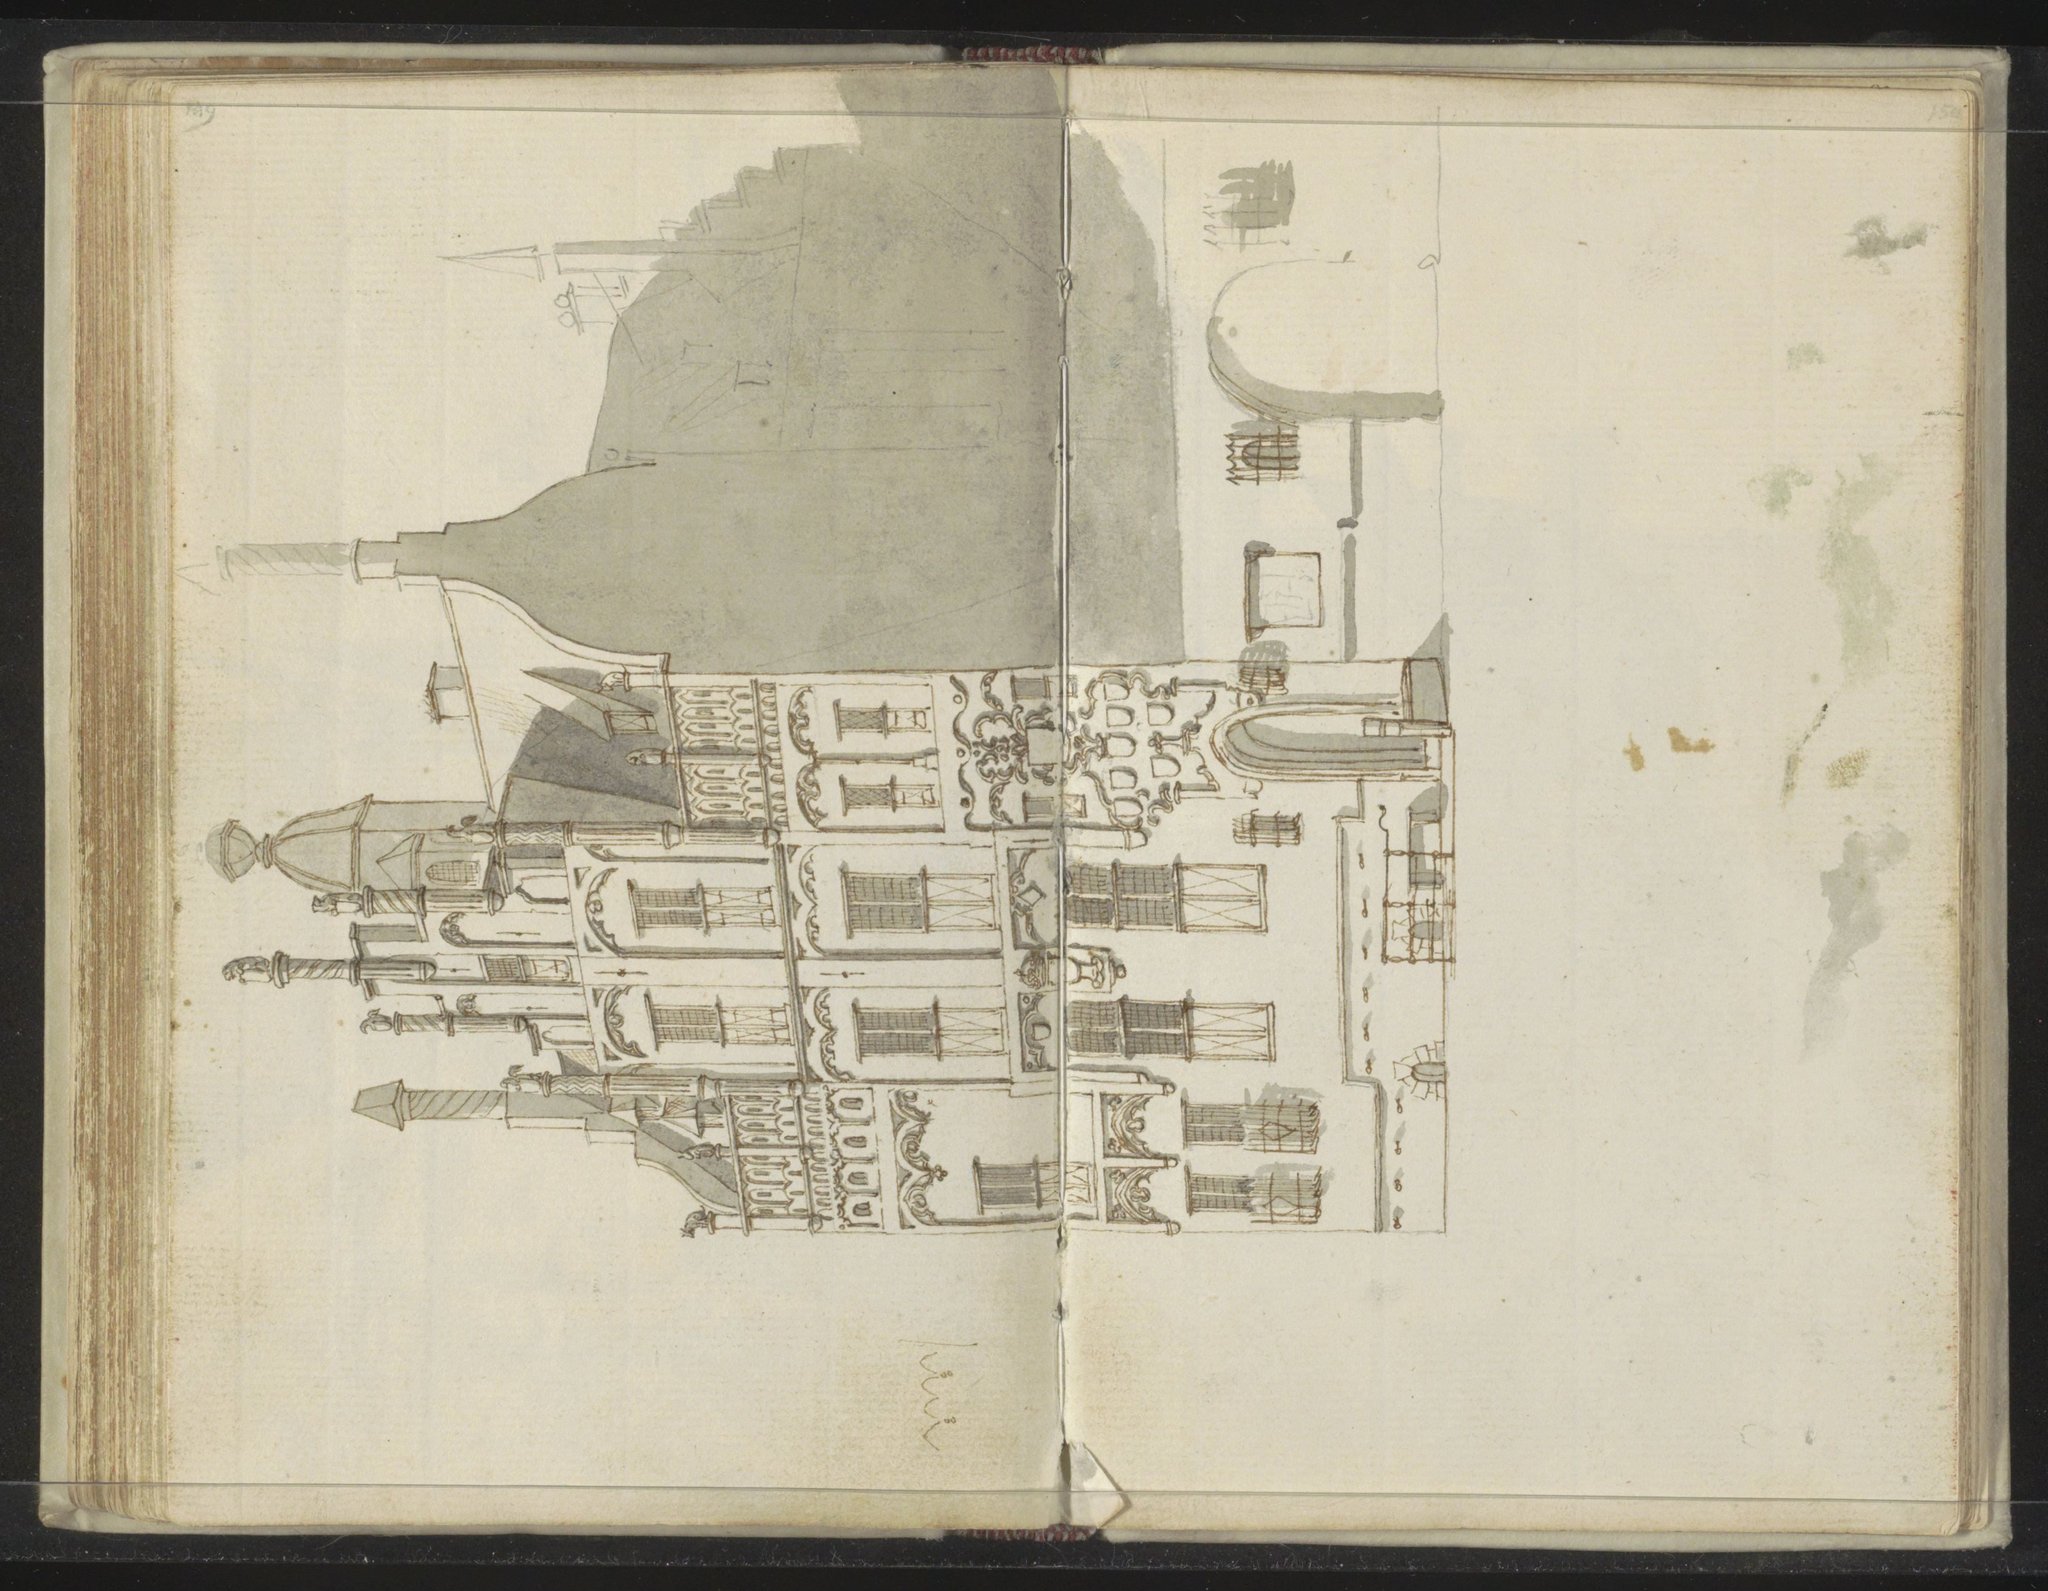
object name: sketchbook leaf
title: Gemeenlandshuis te Delft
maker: johannes huibert prins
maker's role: draughtsman, painter, print maker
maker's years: 1757-1806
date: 1783-1797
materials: ink, paper, pencil, watercolor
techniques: brush, pen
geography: delft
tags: exterior ~ representation of a building, office (~ administration)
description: Pagina 149 en 150 uit een schetsboek met 175 pagina's.